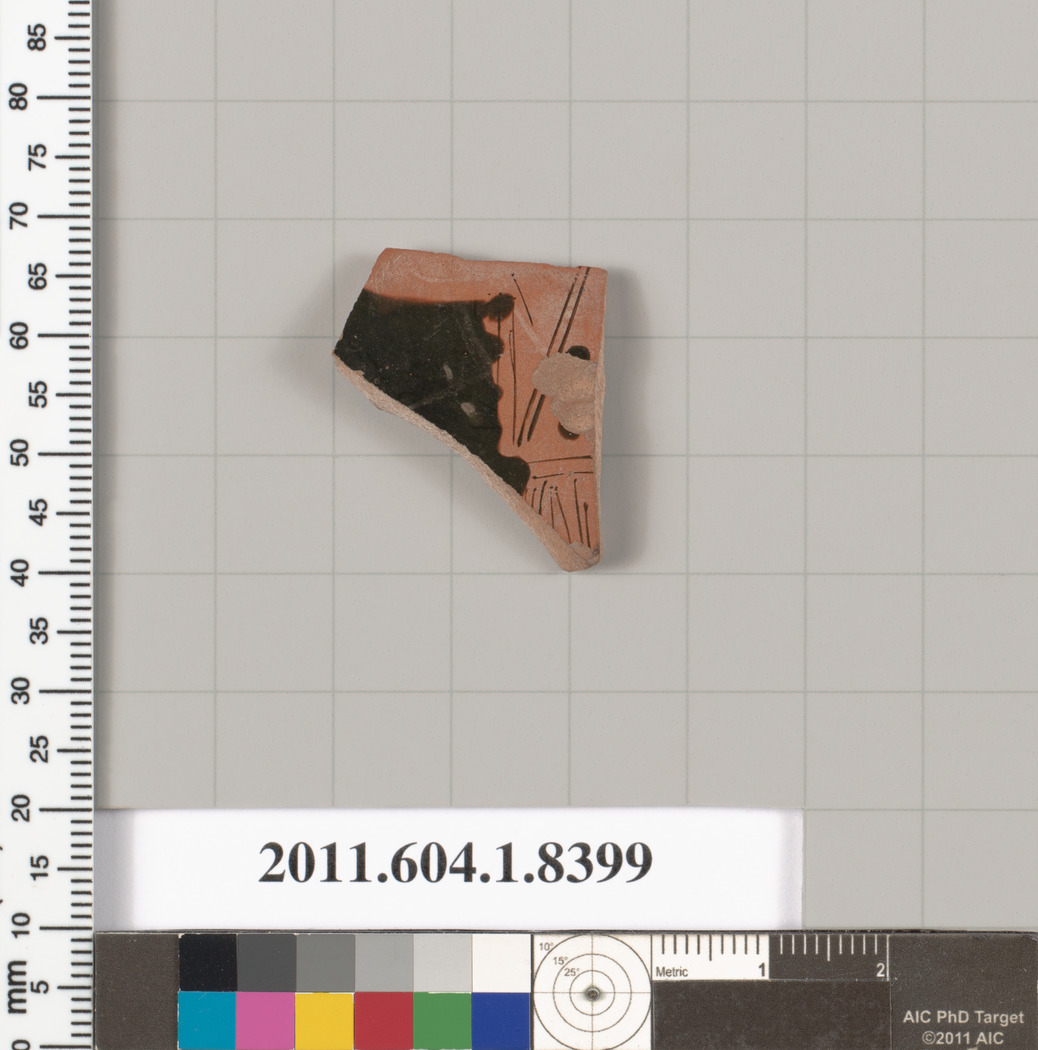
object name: kylix fragment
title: Terracotta fragment of a kylix (drinking cup)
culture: greek, attic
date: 400-351 BCE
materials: terracotta